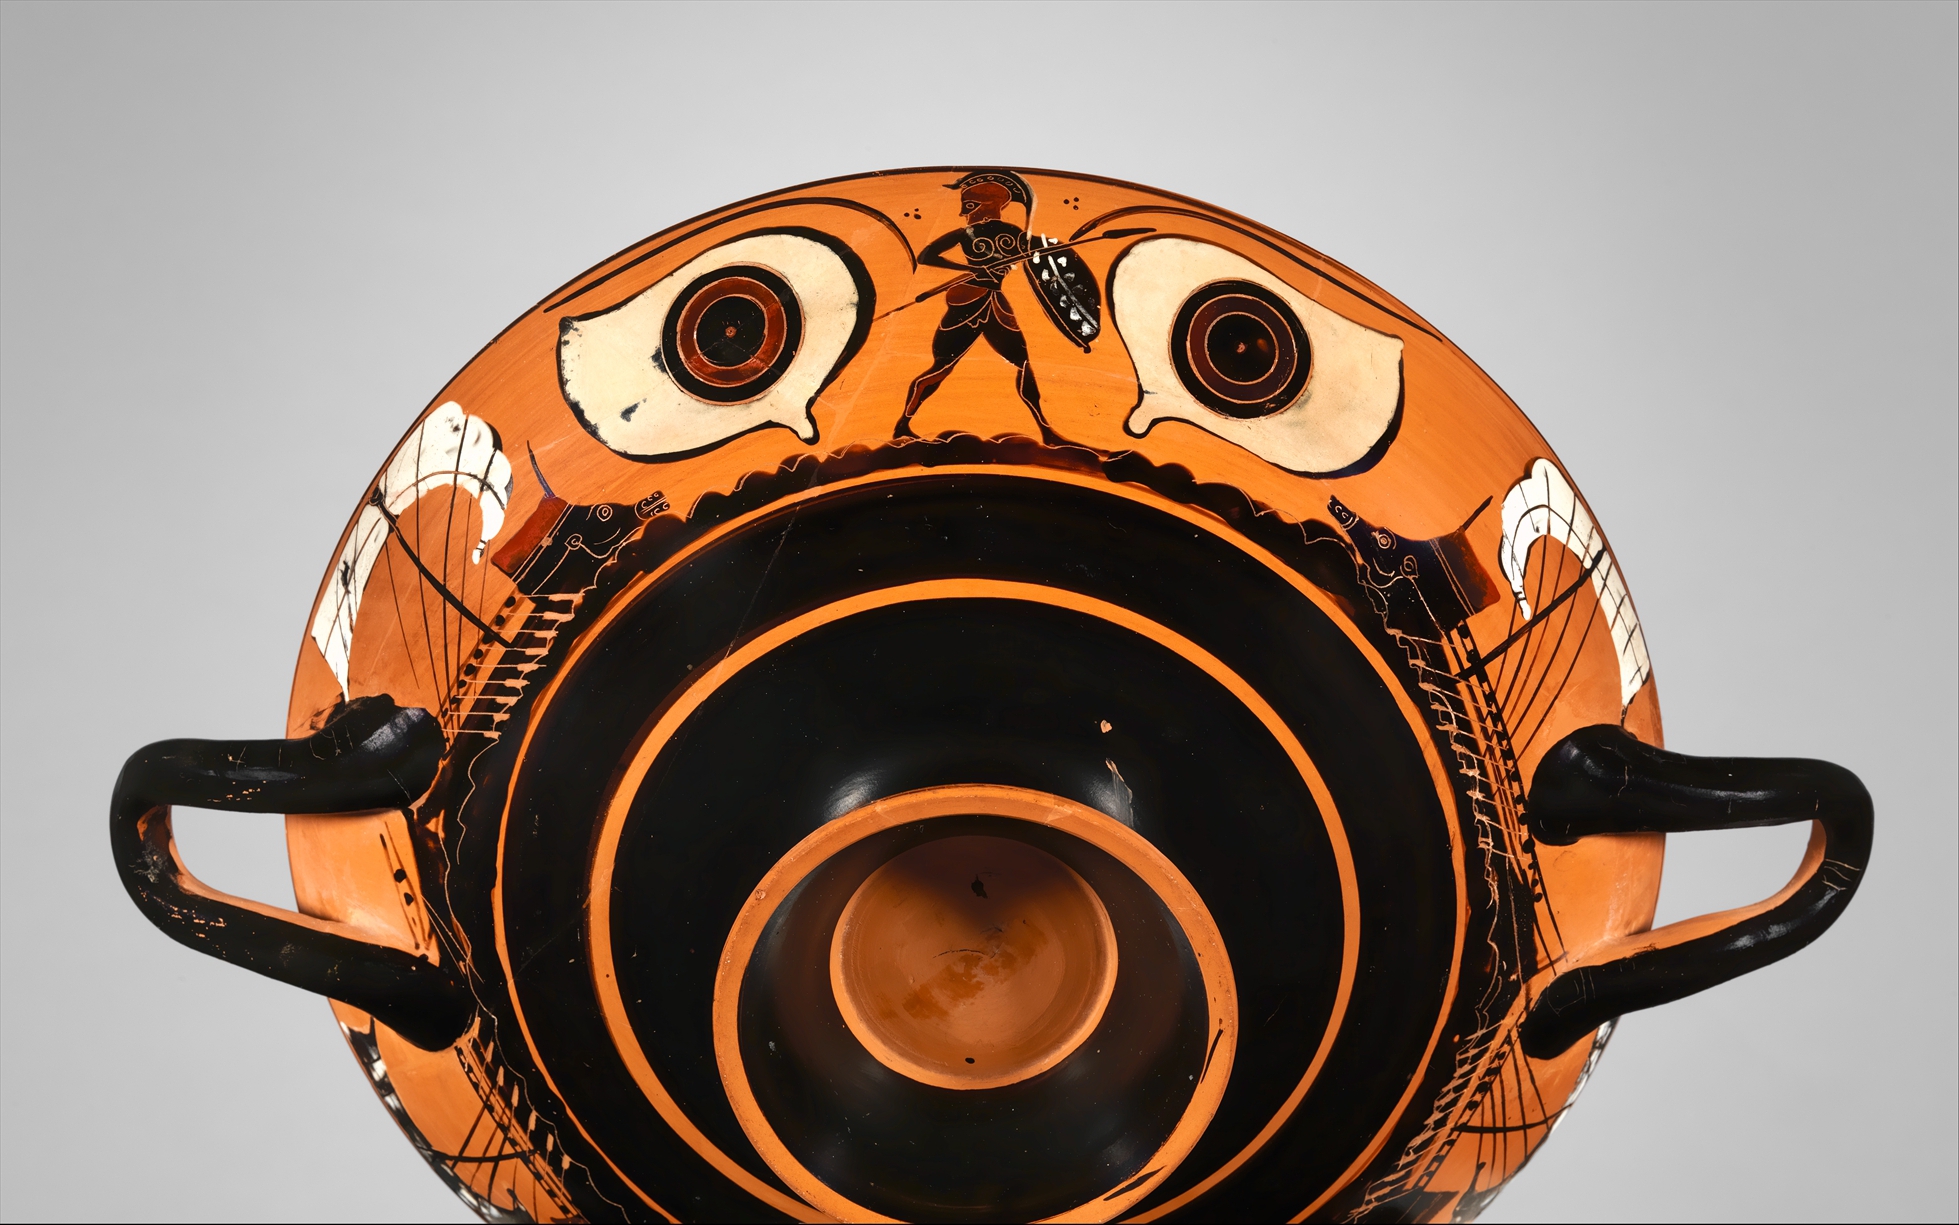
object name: kylix, eye cup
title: Terracotta kylix: eye-cup (drinking cup)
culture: greek, attic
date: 520 BCE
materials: terracotta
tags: eyes,warriors